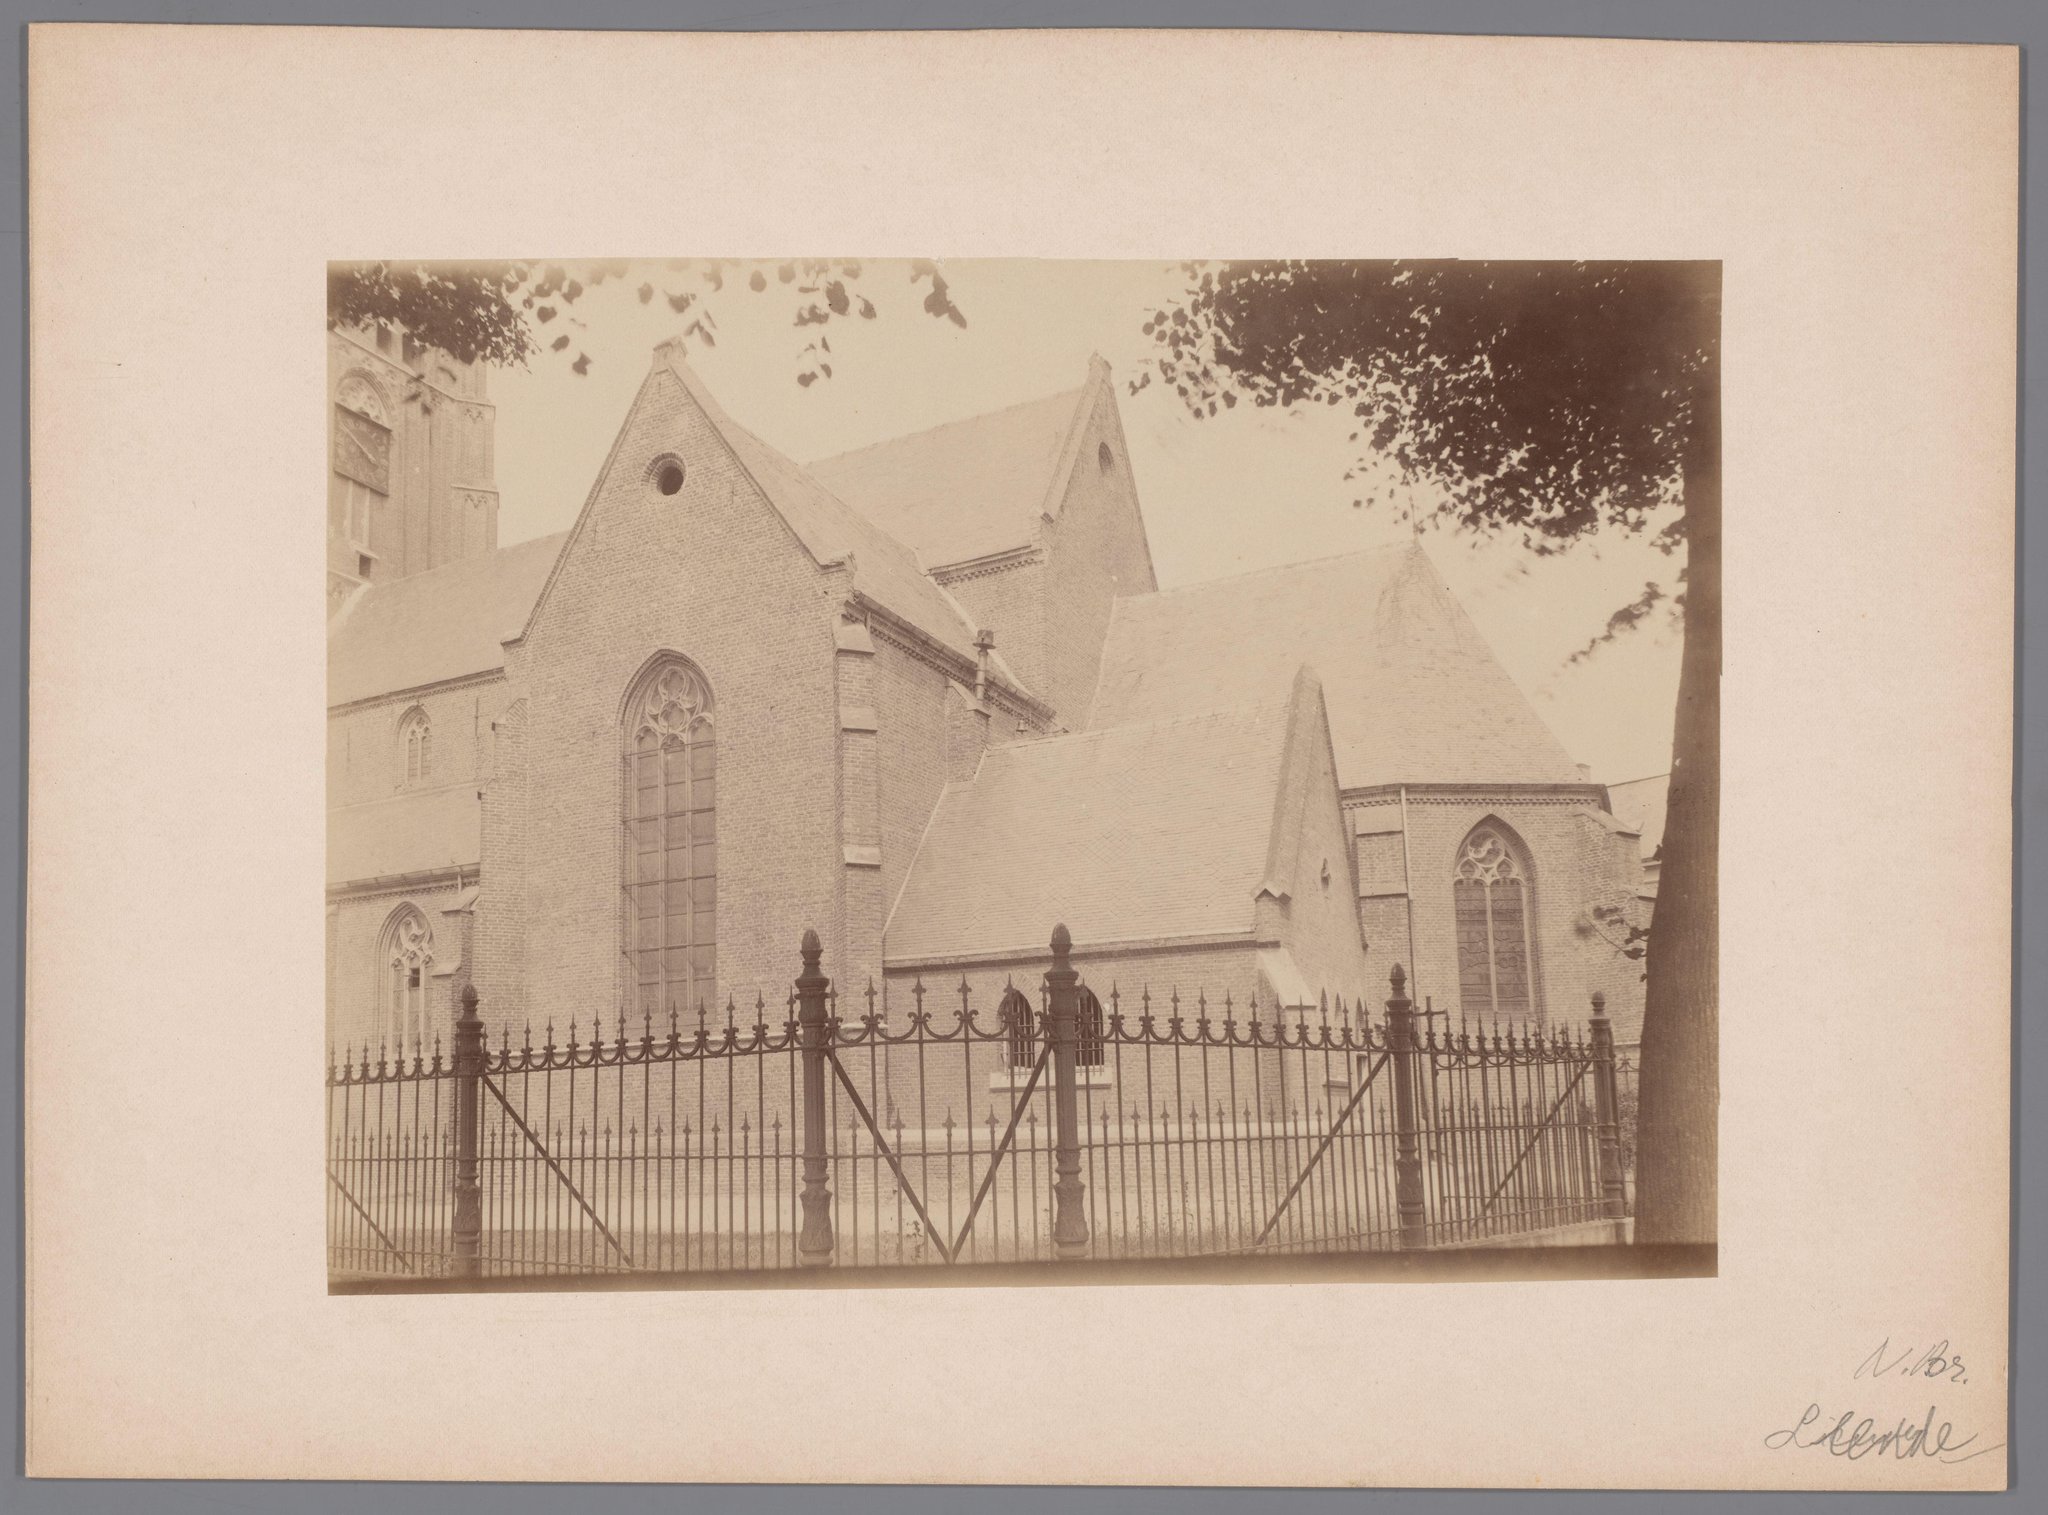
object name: photograph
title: Gedeelte van de Sint-Petrus'-Bandenkerk te Leende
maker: anoniem (monumentenzorg)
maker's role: fotograaf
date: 1904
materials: cardboard, photographic support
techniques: albumen print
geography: leende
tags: church (exterior)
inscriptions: annotation: ‘Leende (N.B.)/ R.K. Kerk/ Juli 1904’, annotation: ‘N.Br. Leende’